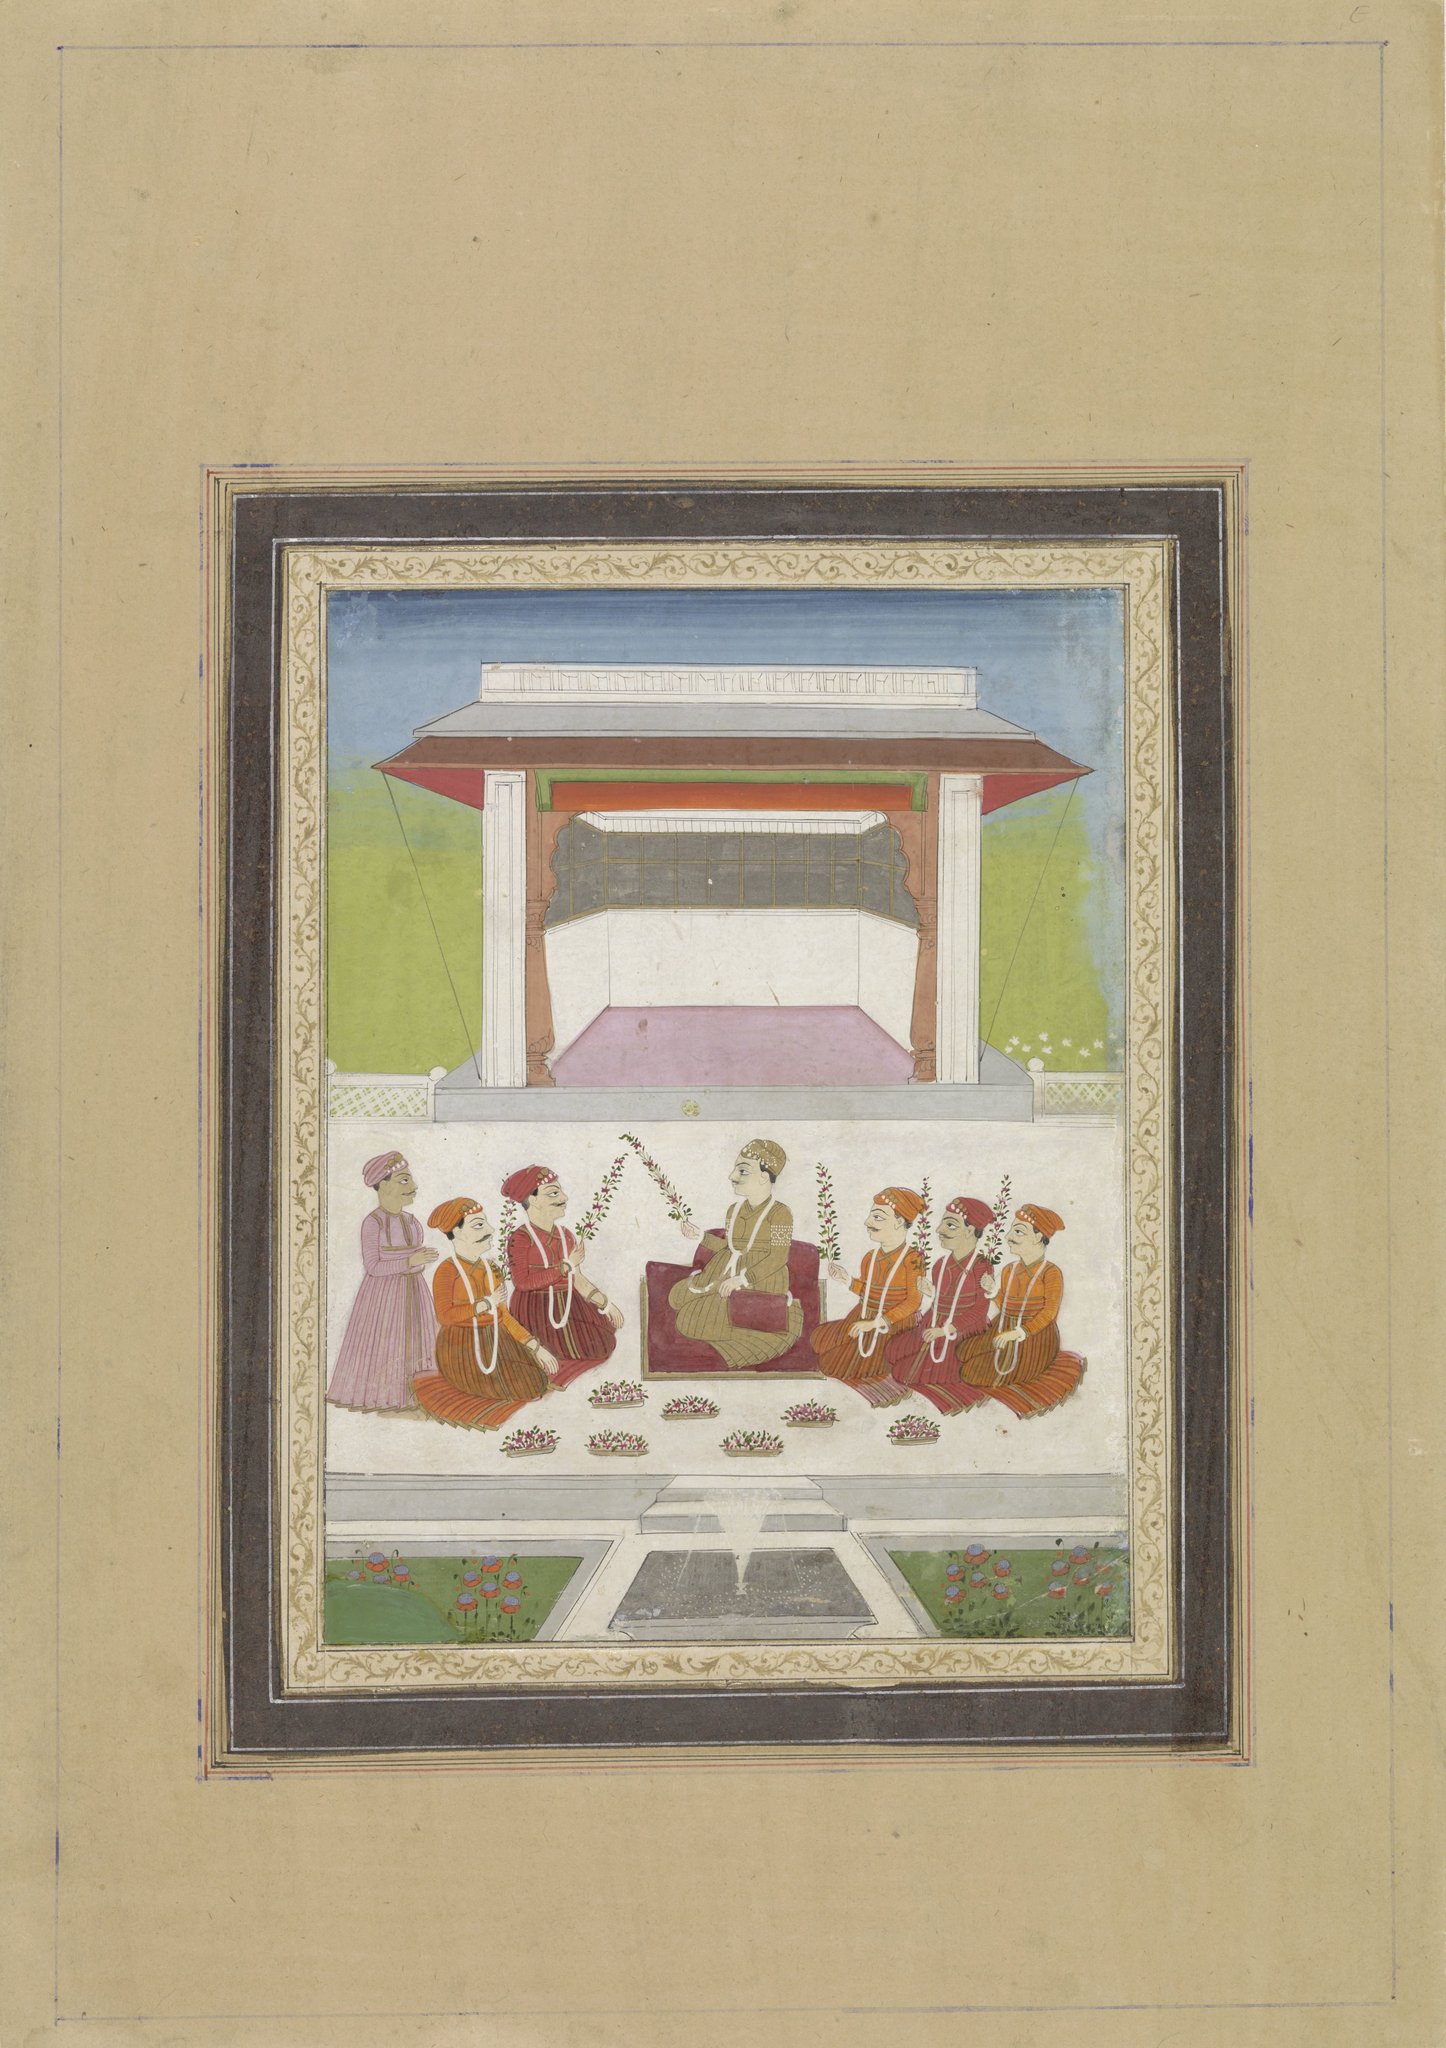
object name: indian miniature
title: Vorsten met bloemtakken op een terras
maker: Anonymous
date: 1790-1810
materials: paper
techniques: brush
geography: shorapur